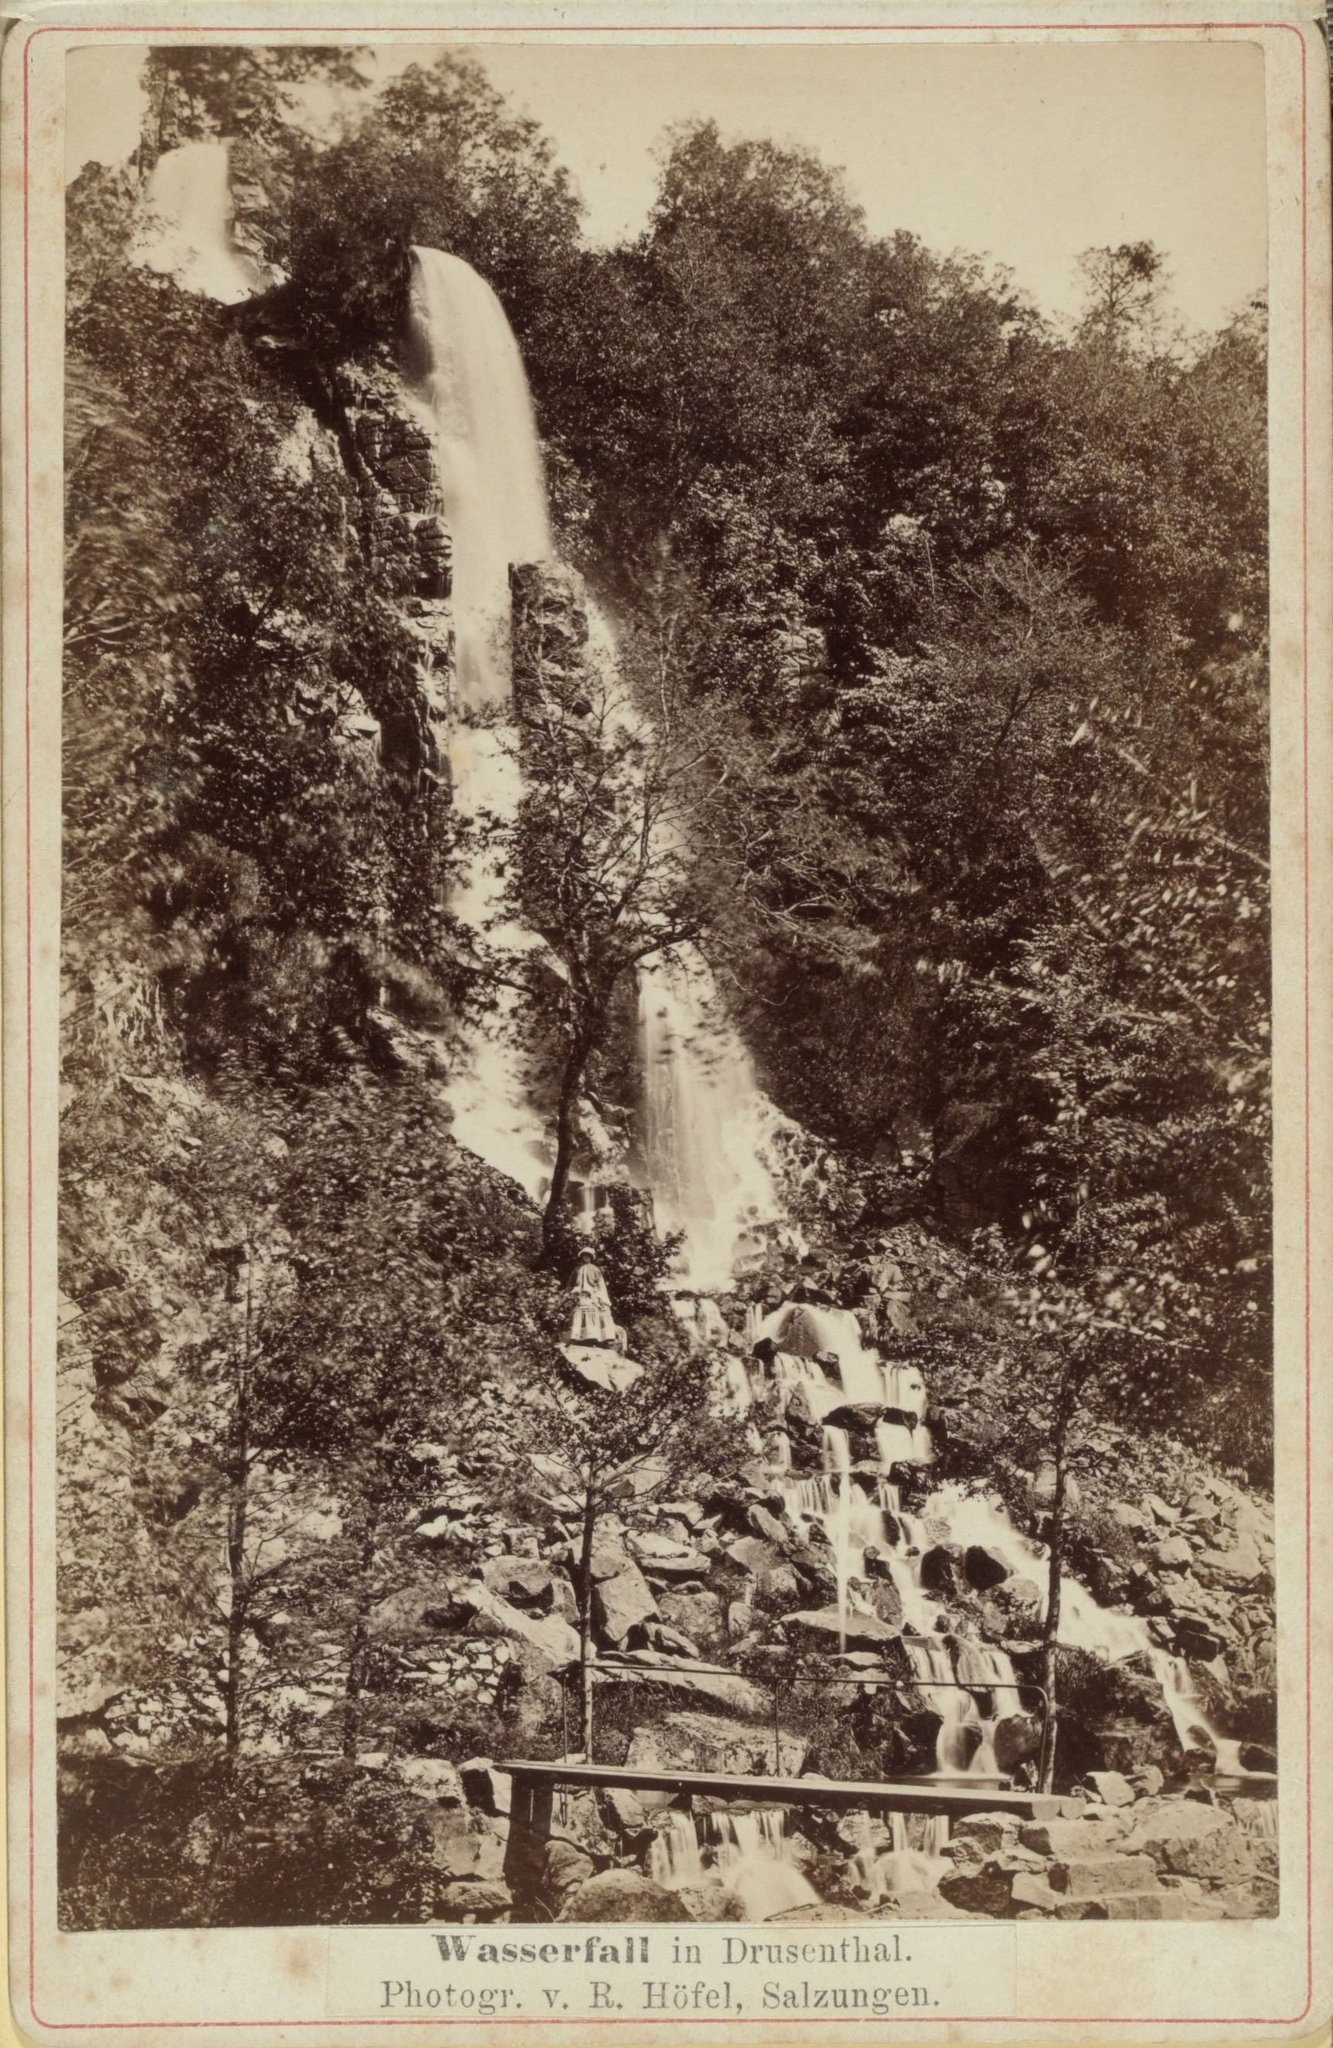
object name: photograph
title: Waterval in het Drusendal in de Harz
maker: r. höfel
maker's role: fotograaf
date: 1870-1890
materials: cardboard, paper, photographic support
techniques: albumen print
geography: harz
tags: waterfall, travelling; tourism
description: Onderdeel van Album met 38 foto's van een reis door de Harz.